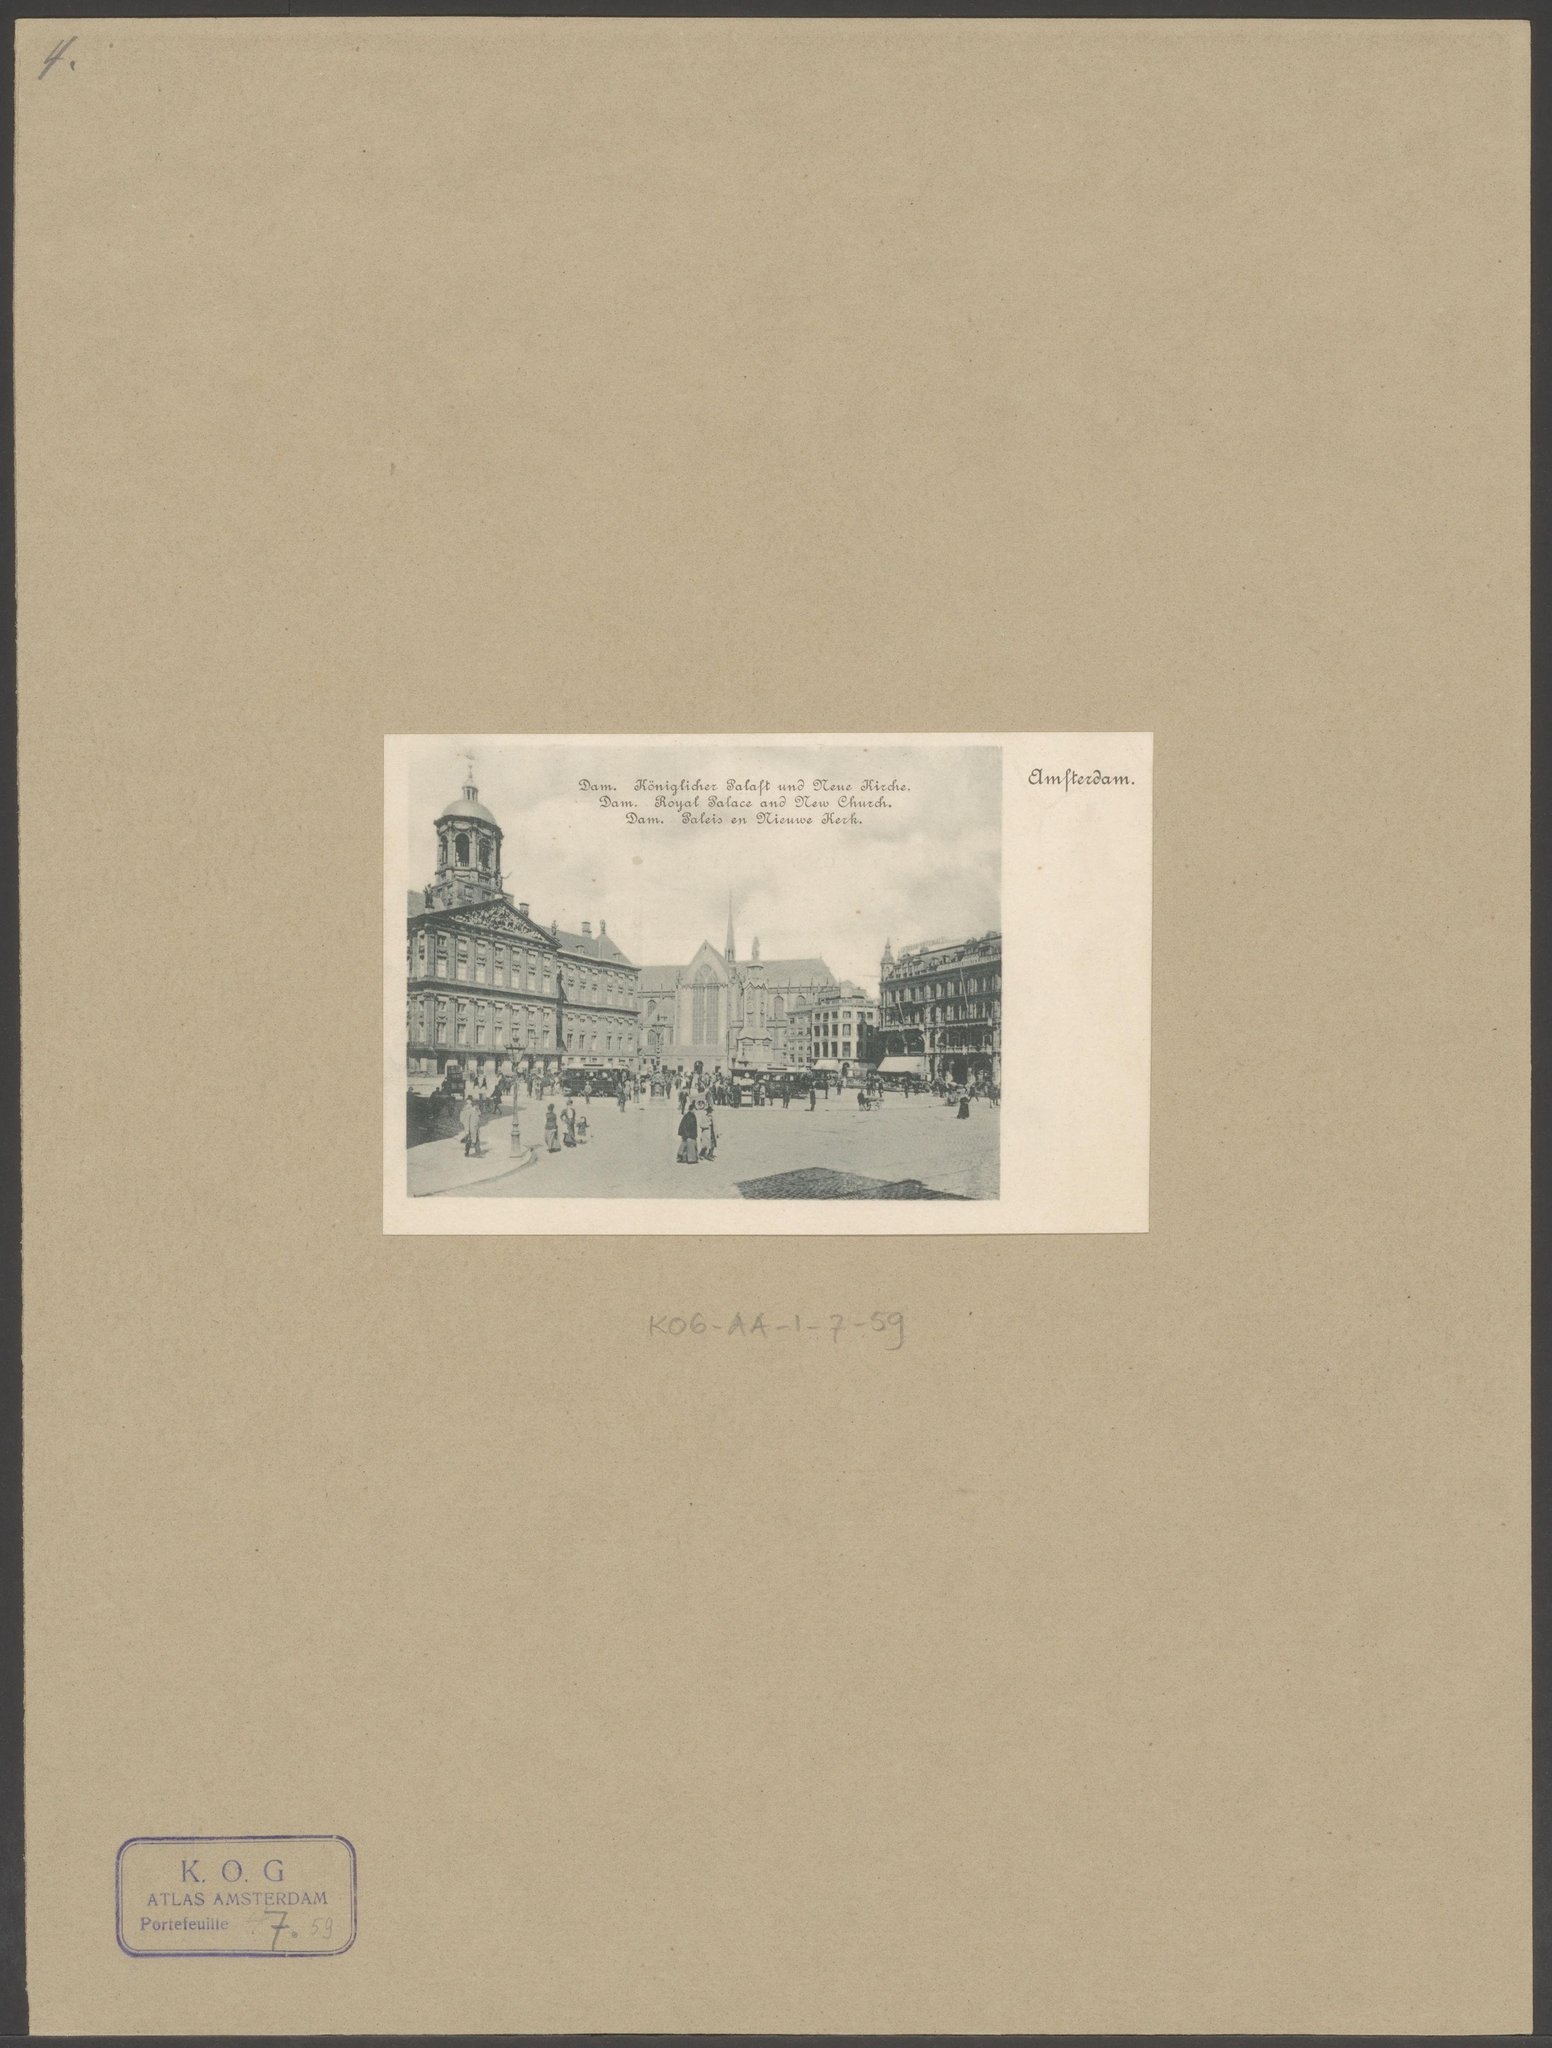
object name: ansichtkaart, prentbriefkaart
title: Gezicht op de Dam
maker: Anonymous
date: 1875-1930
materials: paper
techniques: photograph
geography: amsterdam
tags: square, place, circus, etc., city-view in general; 'veduta', palace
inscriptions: collector's mark: ‘7’ Lugt 1641b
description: Onderwerpsrubriek binnen de Atlas Amsterdam: Dam (na 1835).